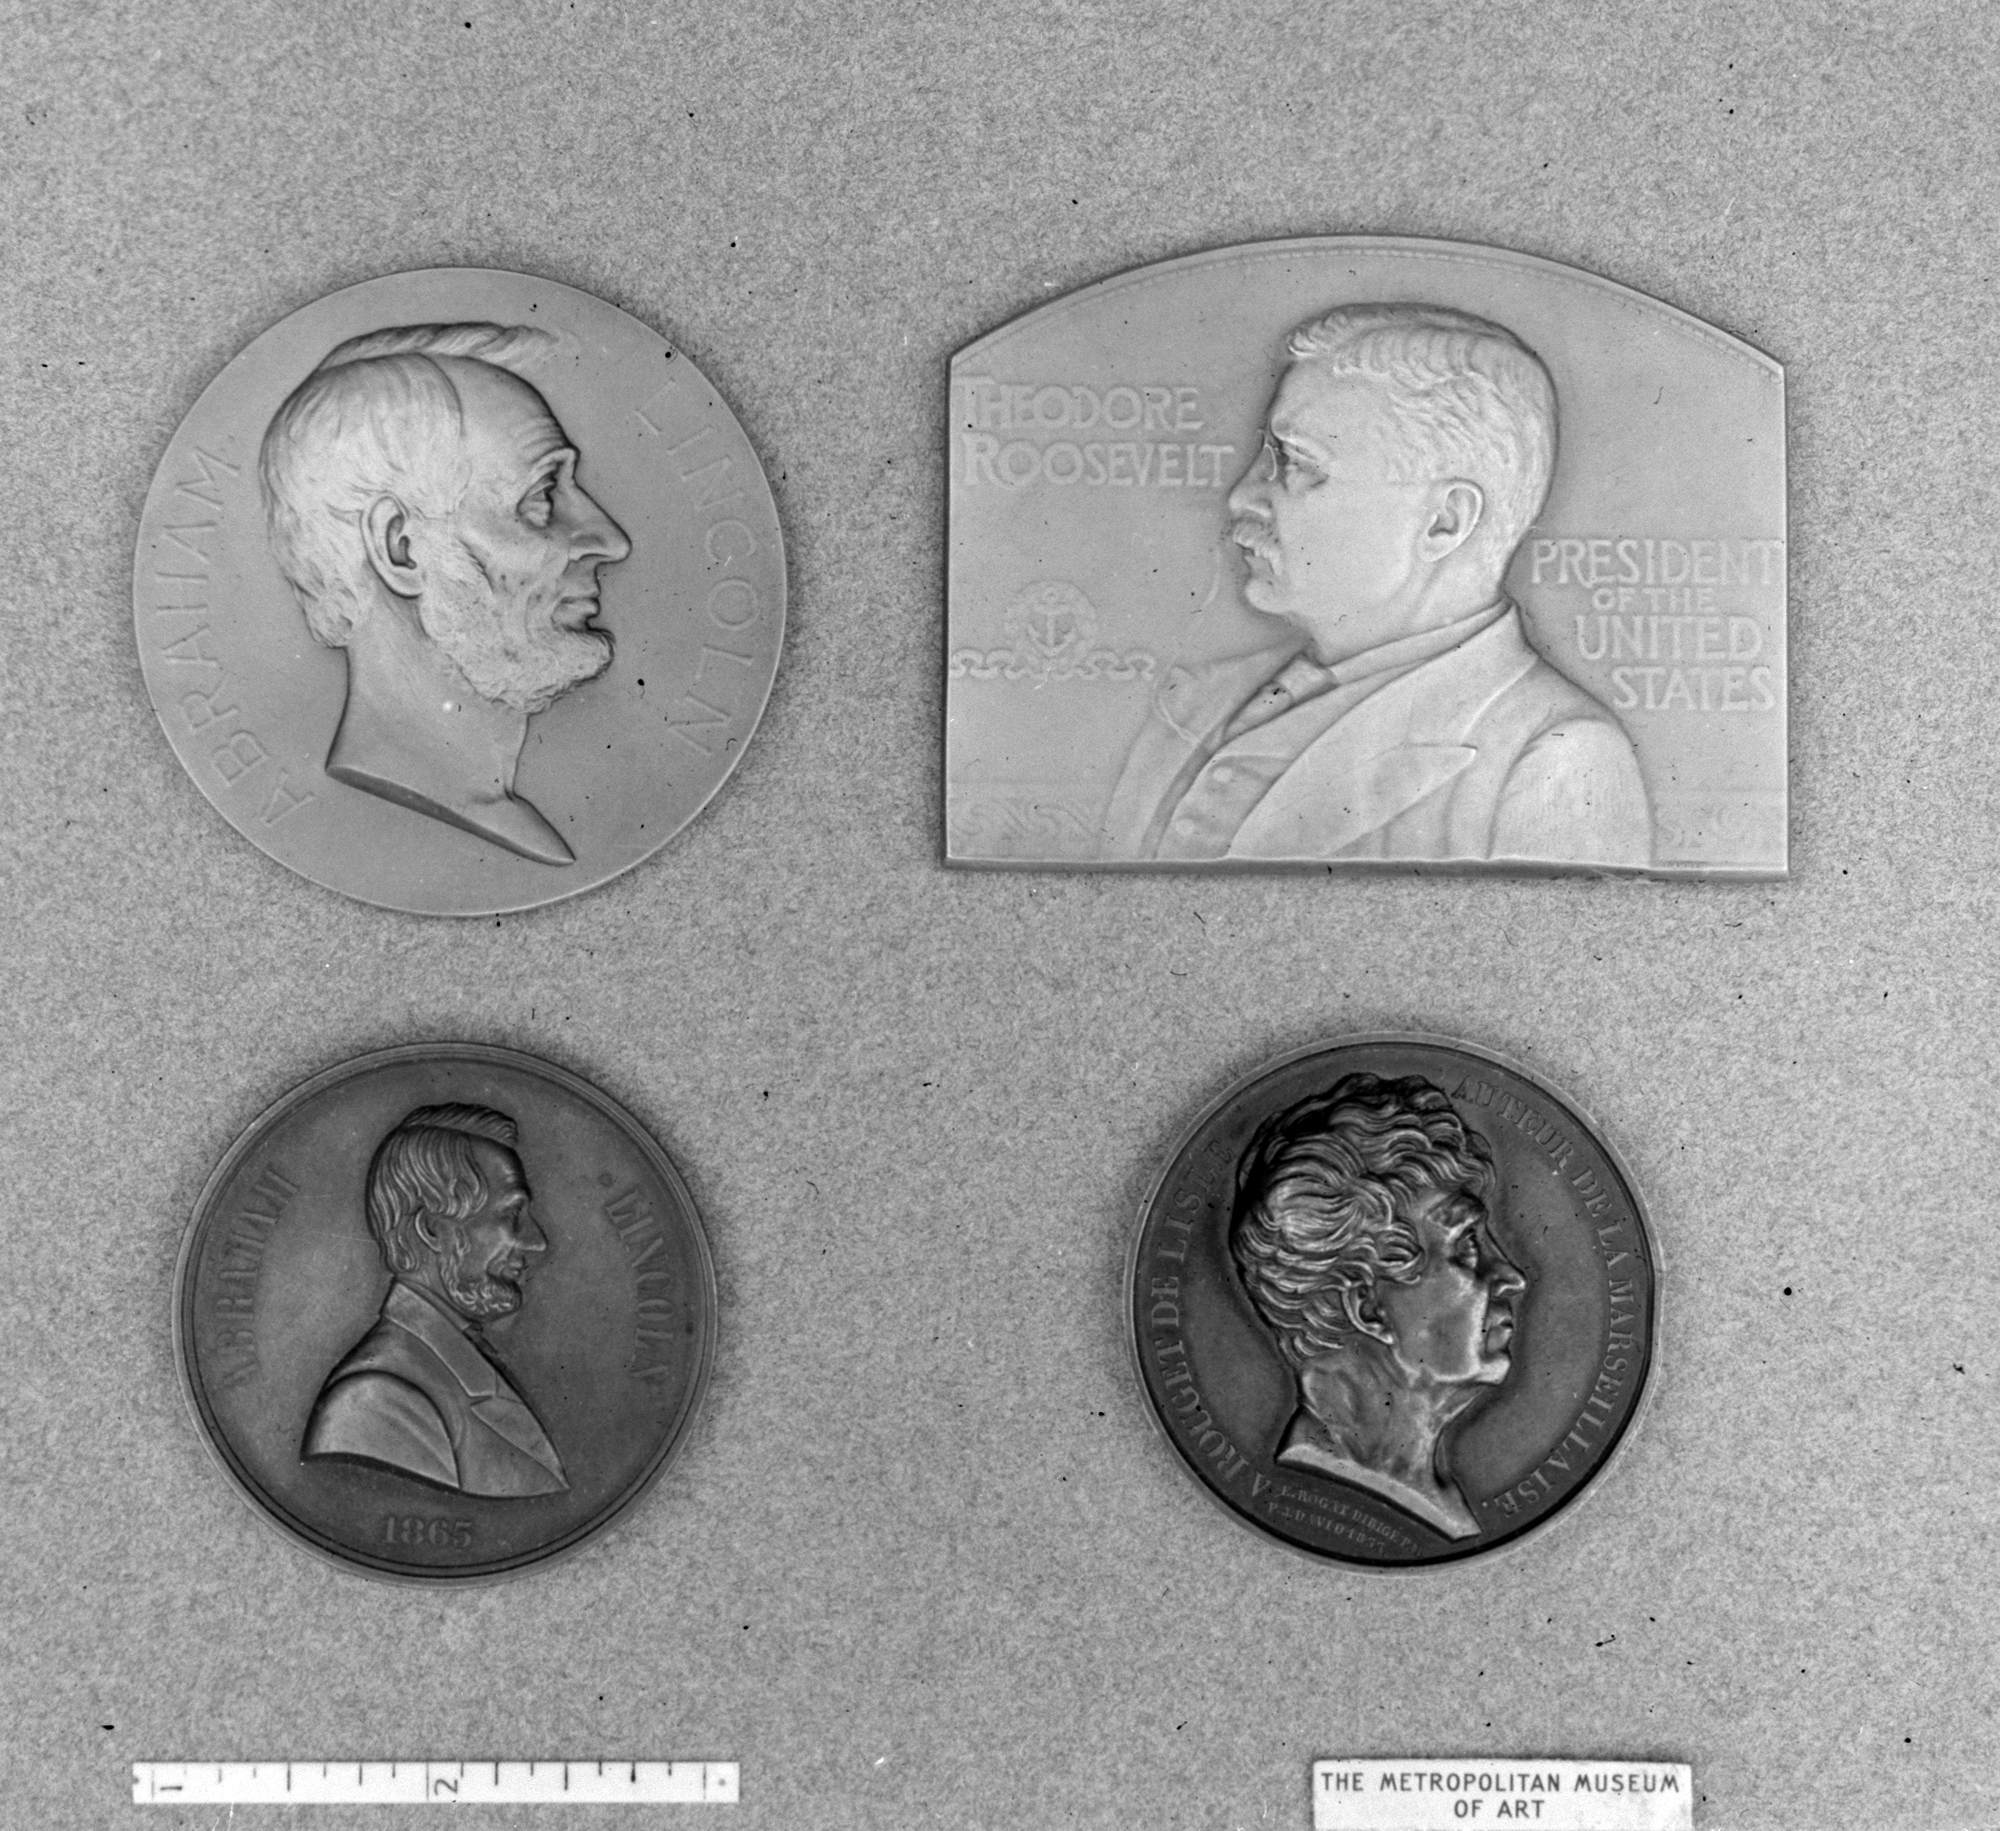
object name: medal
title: Rouget de Lisle, Author of the Marseillaise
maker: emile rogat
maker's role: artist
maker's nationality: french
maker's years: 1770-1850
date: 1801-1900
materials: bronze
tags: abraham lincoln,men,profiles